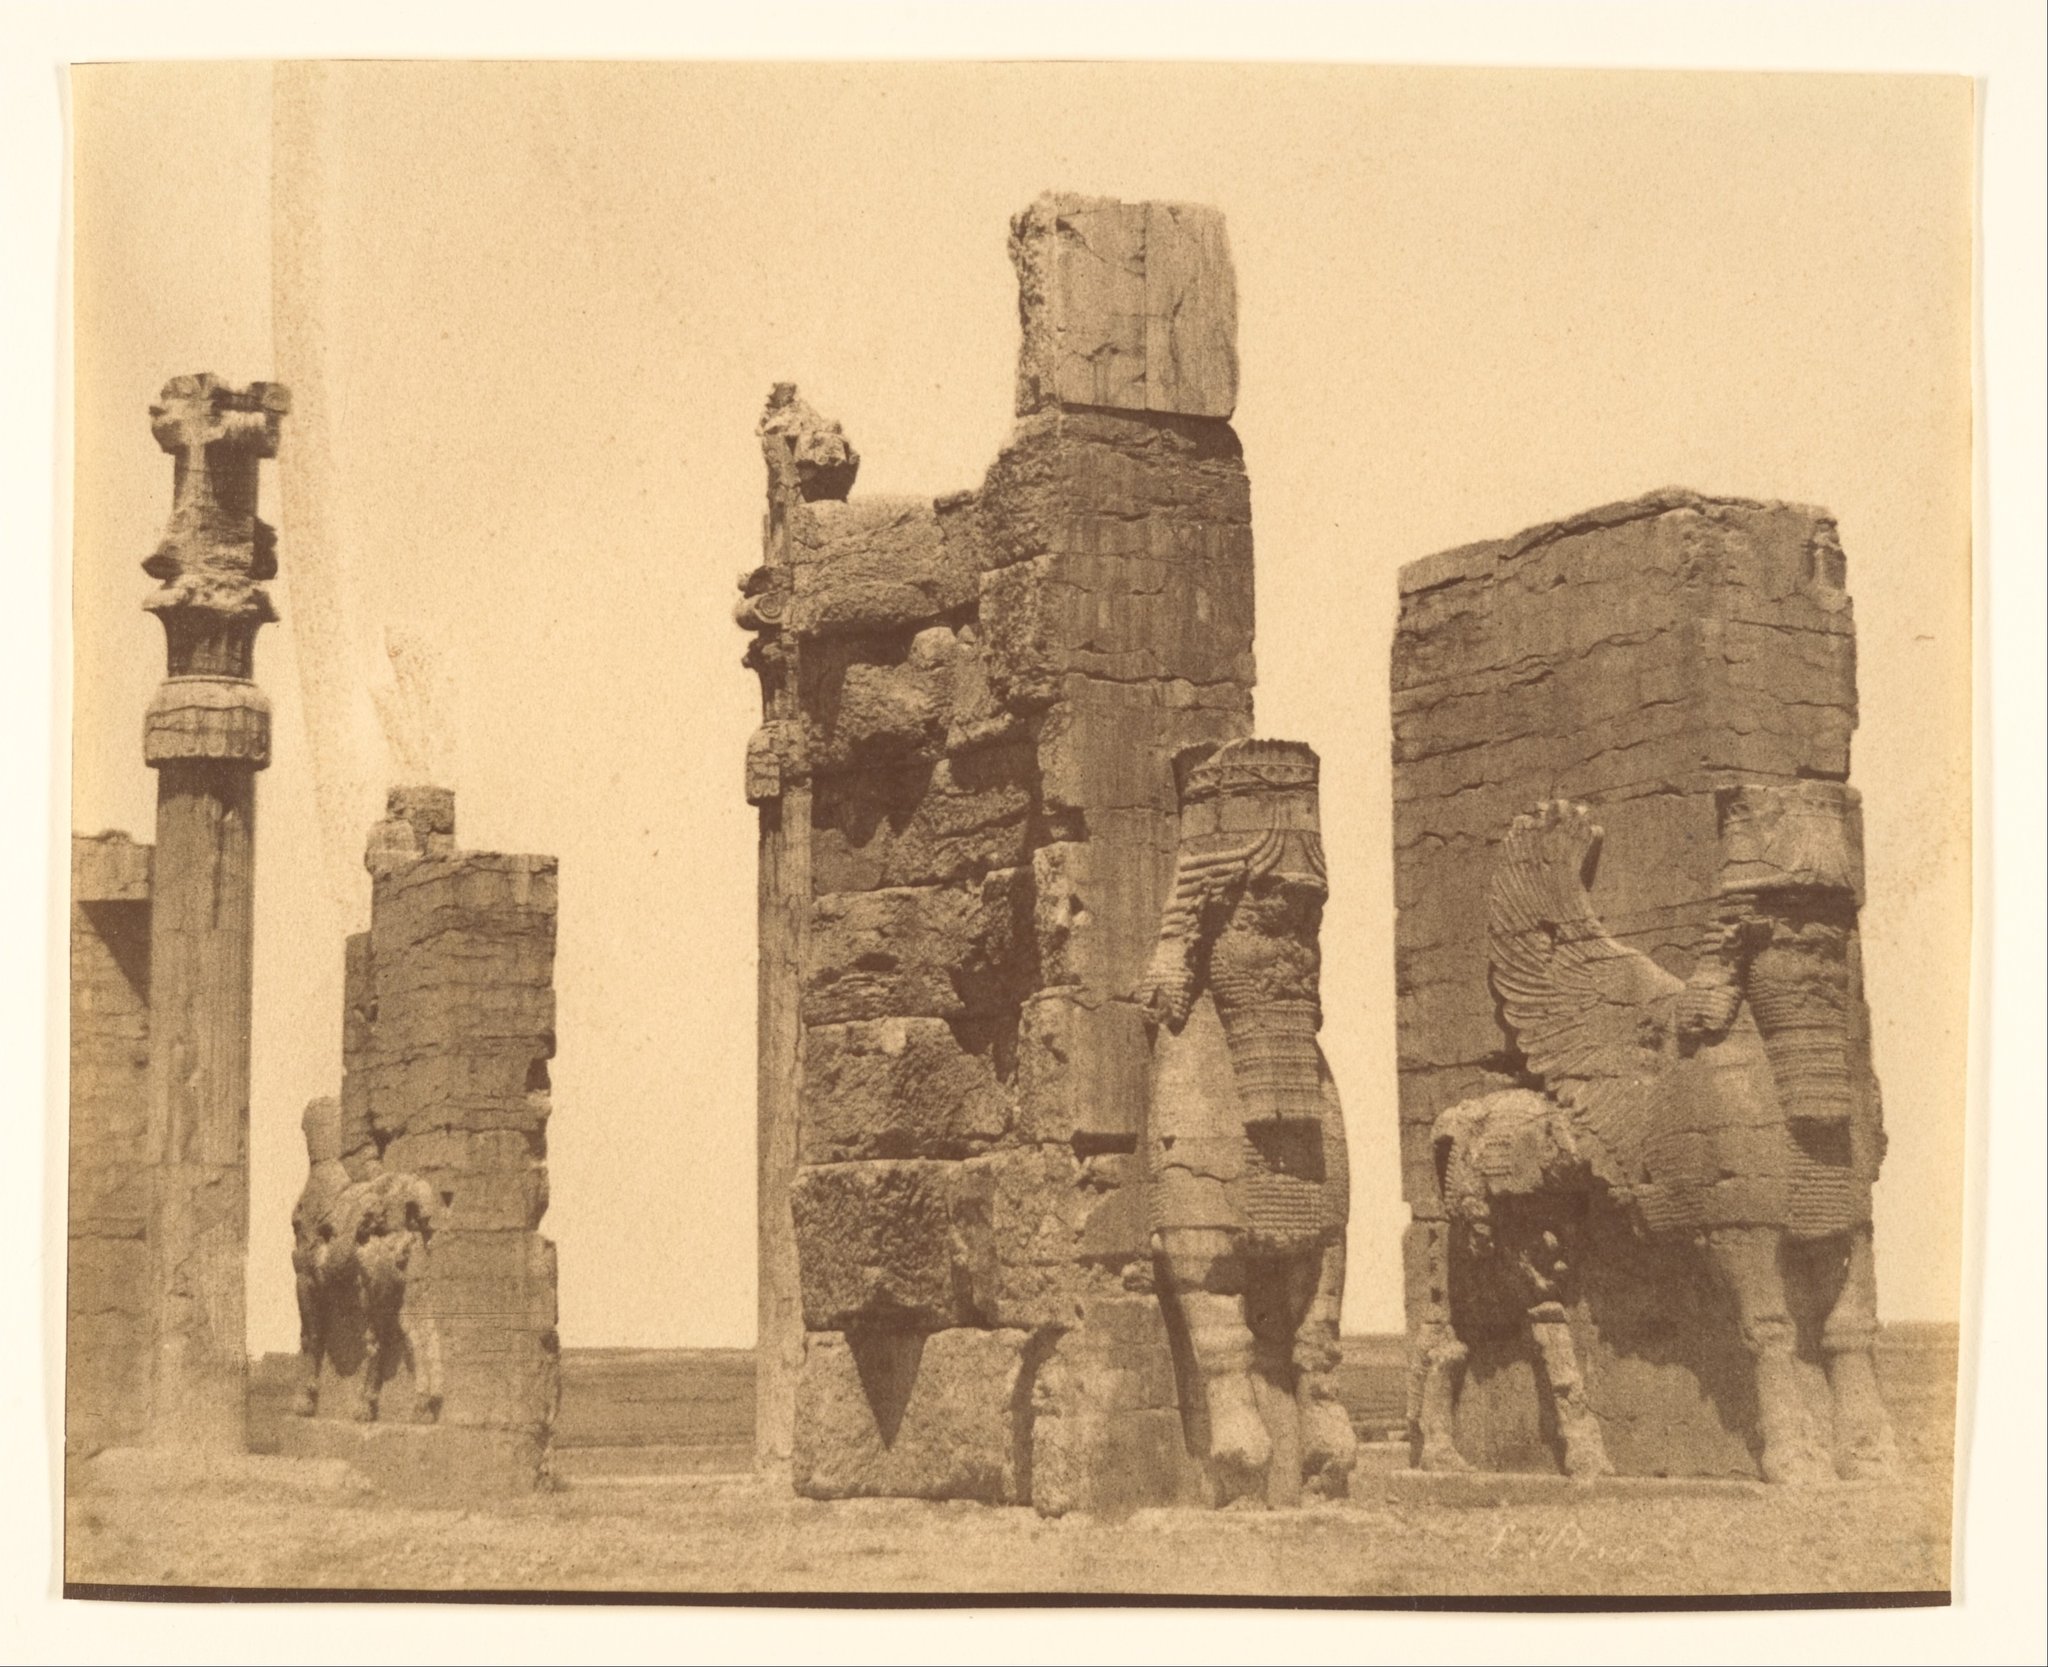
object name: photograph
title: (15) [Gate of all Nations, Persepolis, Fars]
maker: luigi pesce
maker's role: artist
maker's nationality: italian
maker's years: 1818-1891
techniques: albumen silver print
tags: architecture,gates,ruins